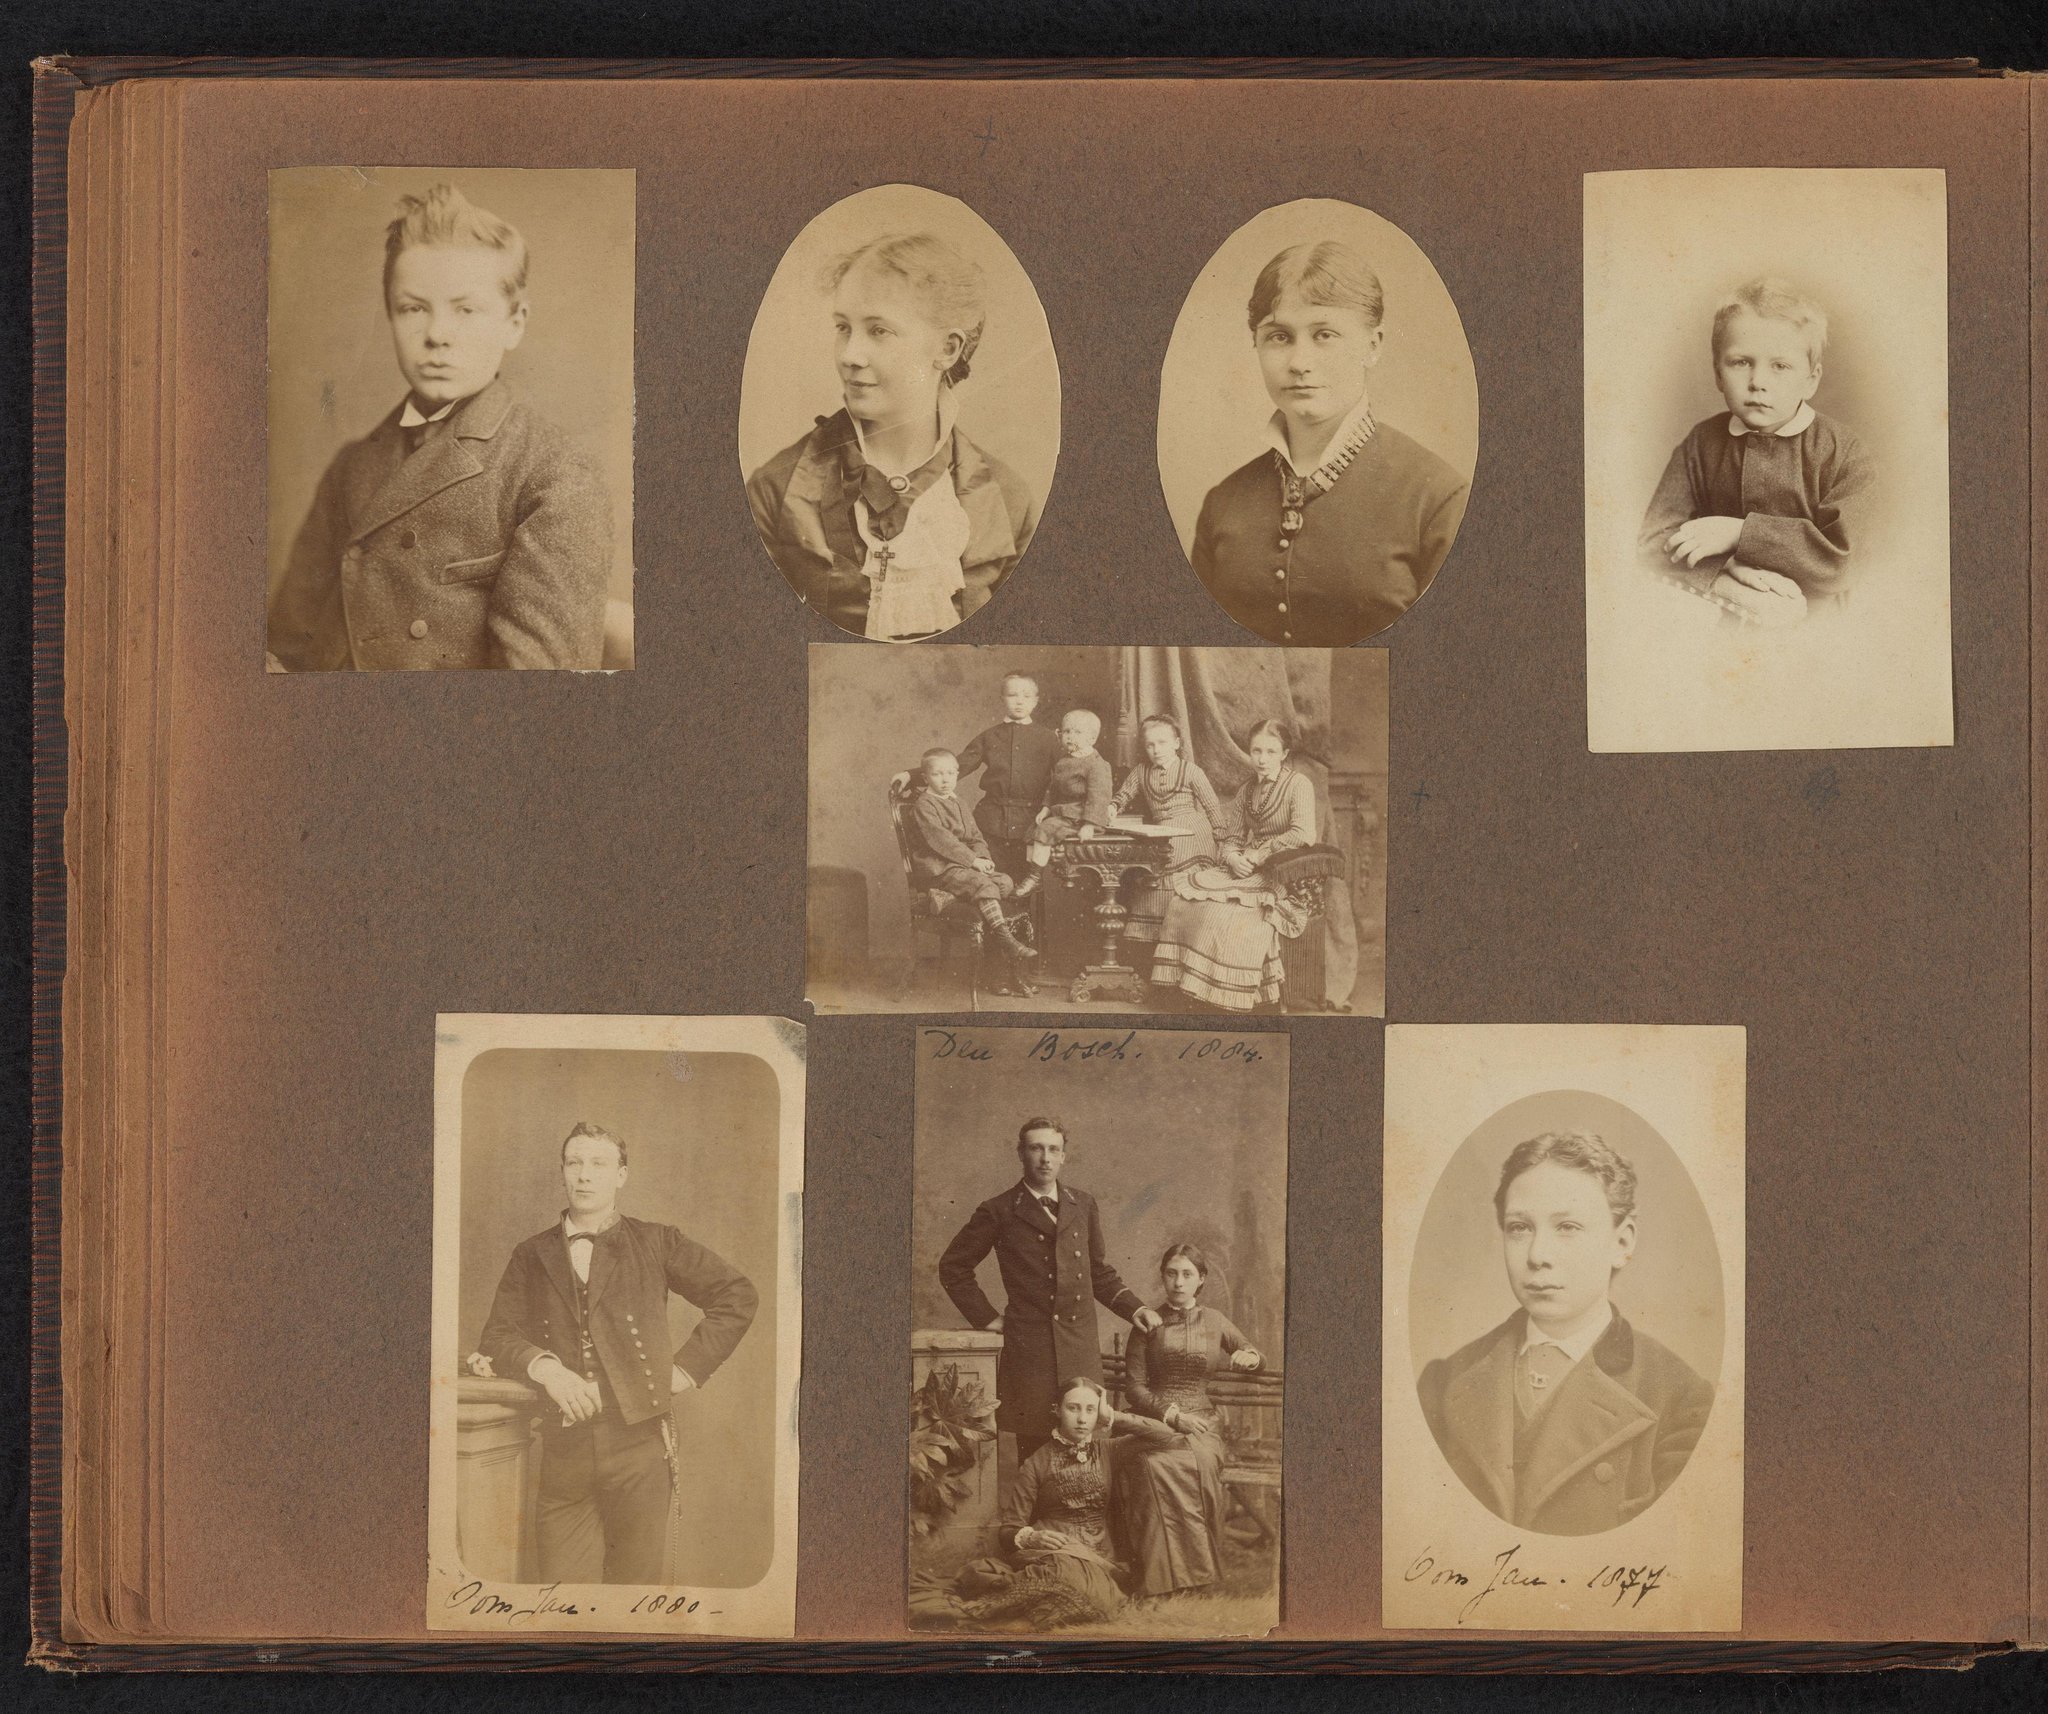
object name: album leaf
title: Bladzijde uit het fotoalbum van de familie Diepenbrock met 8 foto's van Alphons Diepenbrock en zijn omgeving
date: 1877-1884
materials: cardboard, photographic support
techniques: photography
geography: netherlands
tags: den bosch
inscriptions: inscription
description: Bruin albumblad 16 van familiealbum van Alphons Diepenbrock.